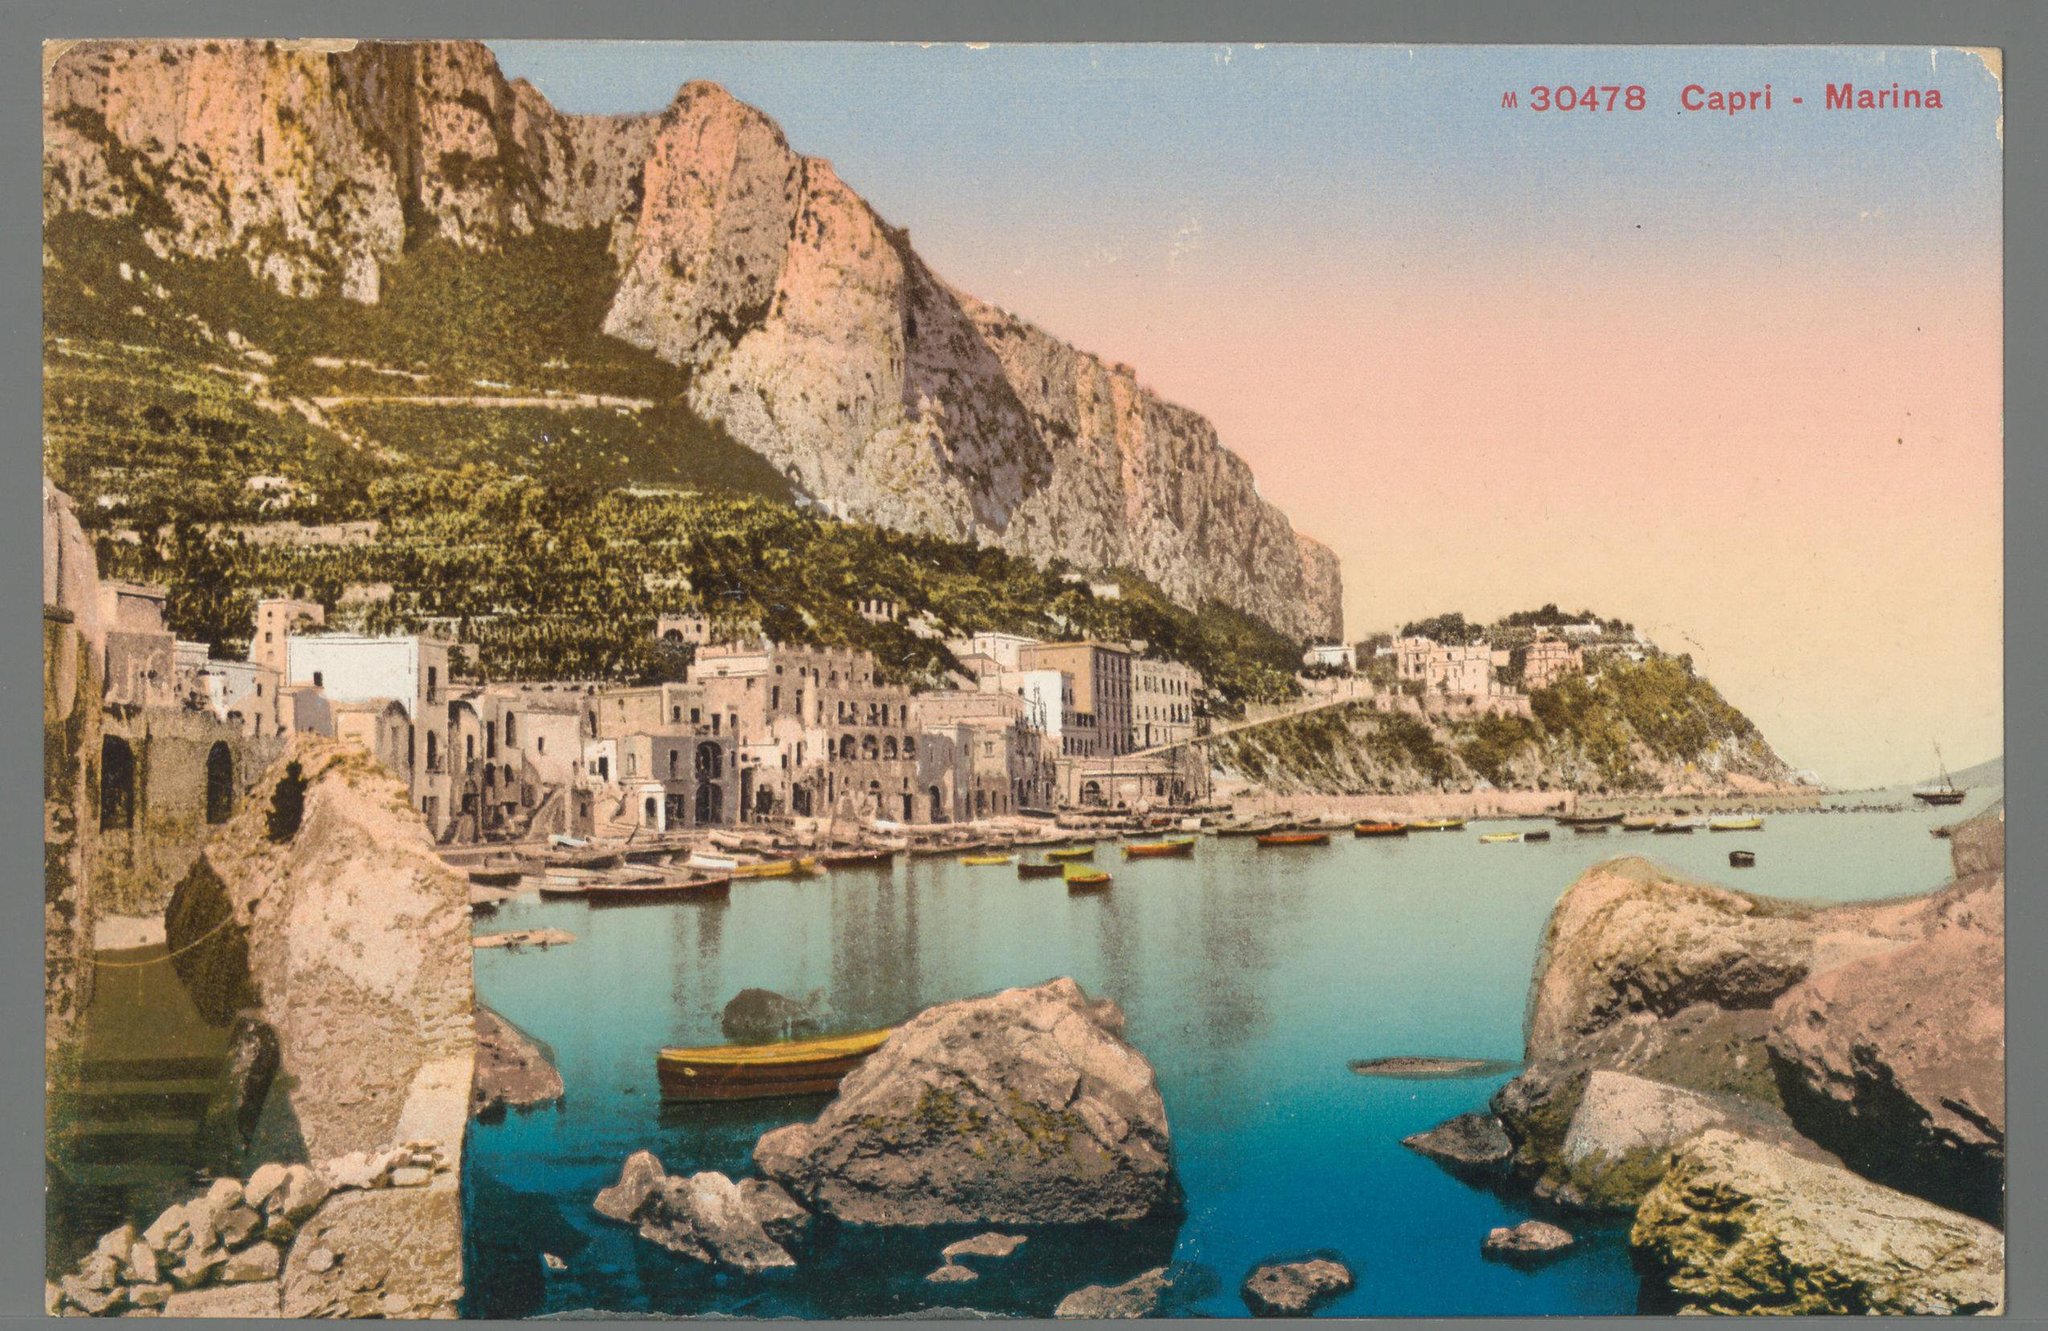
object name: ansichtkaart, prentbriefkaart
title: Capri. Marina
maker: Anonymous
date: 1905-1930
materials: cardboard, photographic process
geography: capri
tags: harbour, gulf, bay, prospect of city, town panorama, silhouette of city